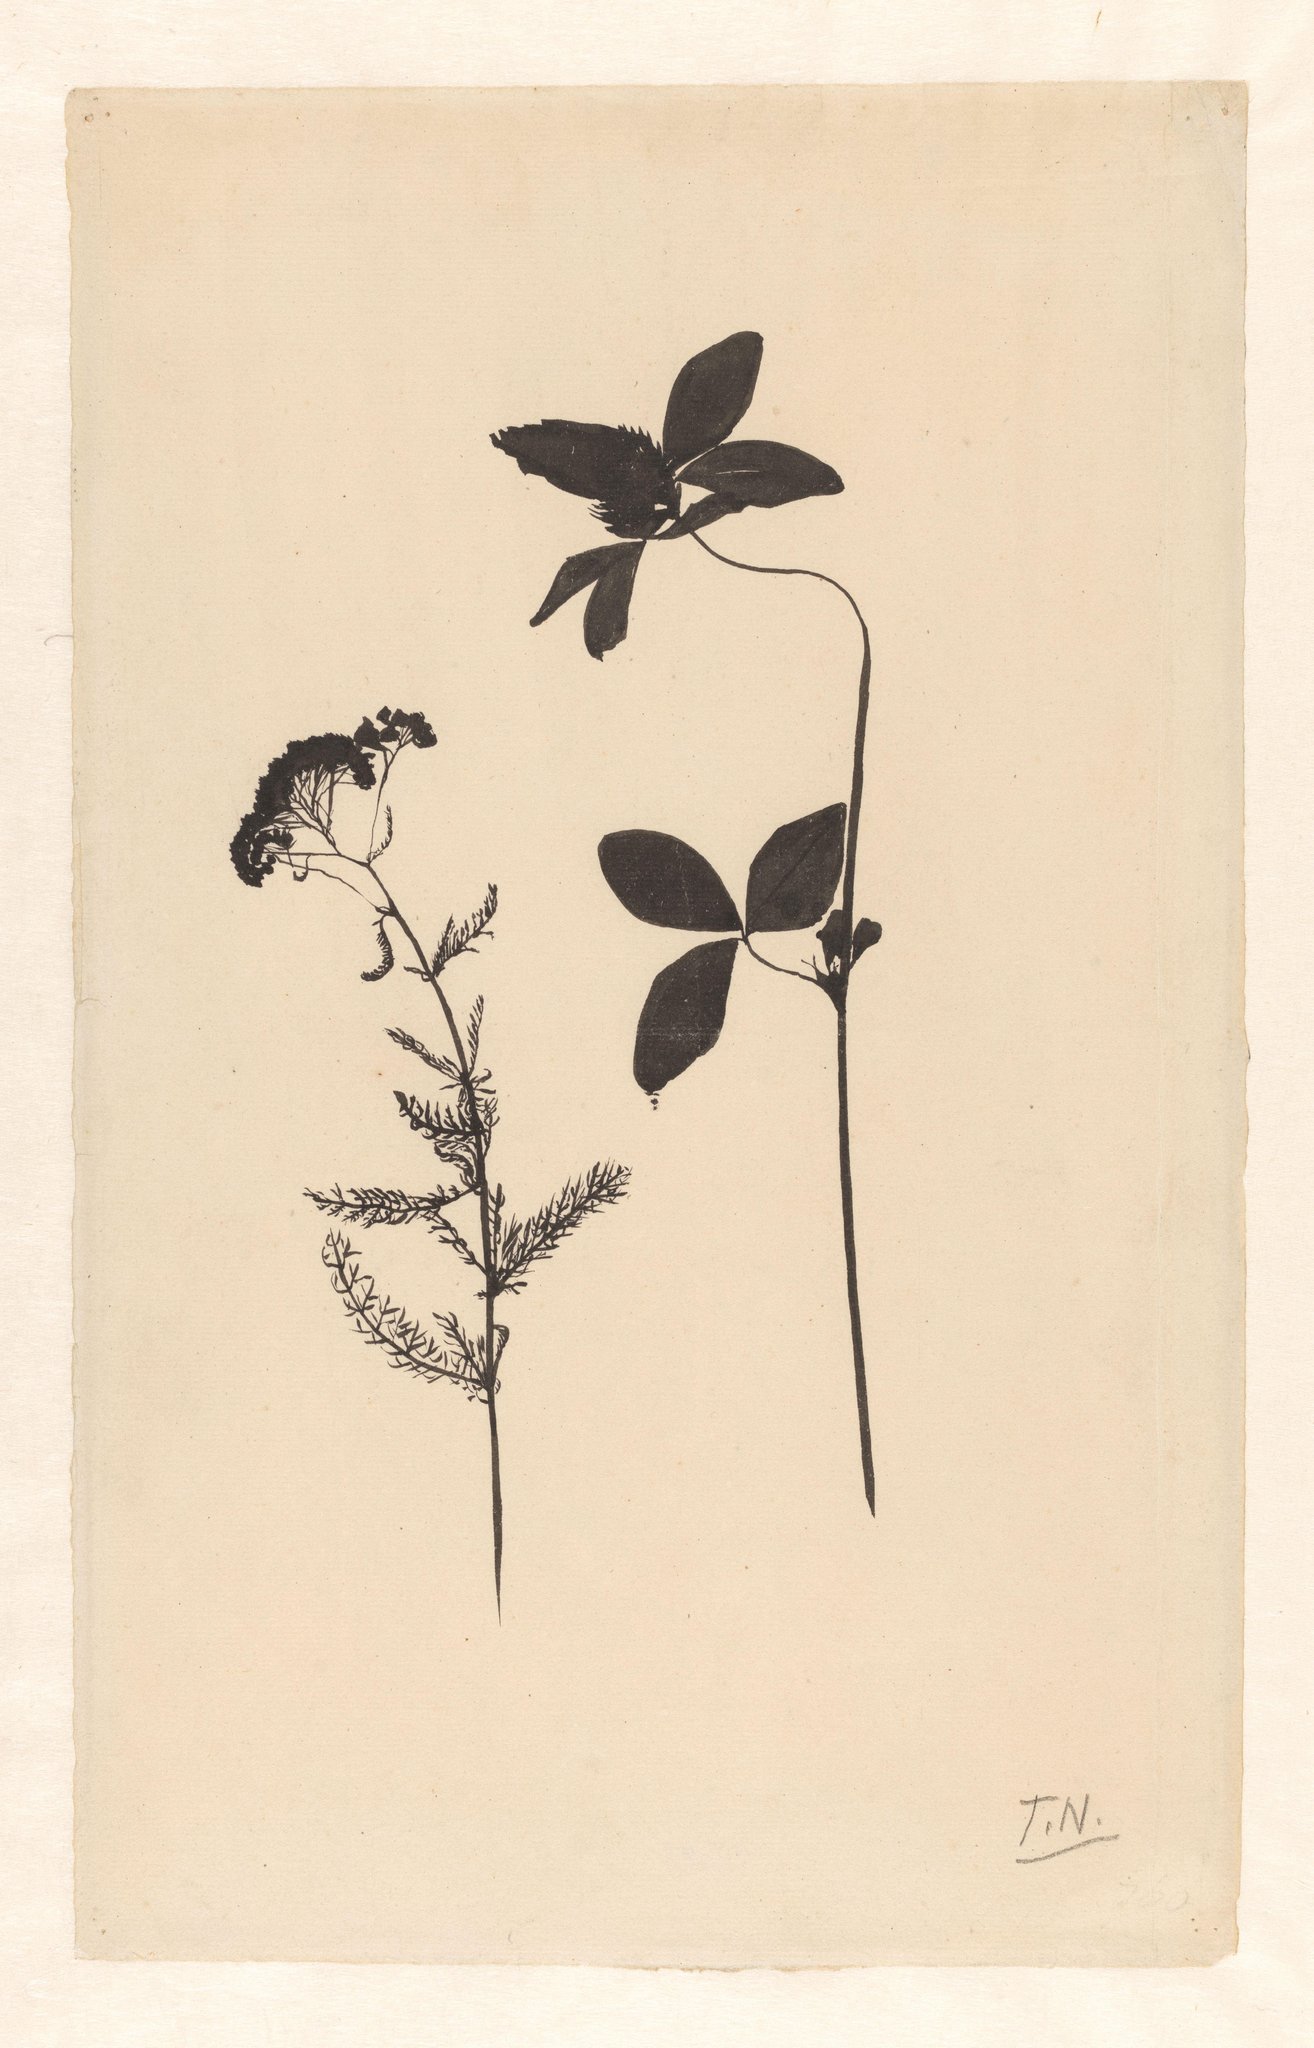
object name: drawing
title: Klaver en een andere plant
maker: theo nieuwenhuis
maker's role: designer, draughtsman, print maker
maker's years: 1866-1951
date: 1876-1951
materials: paper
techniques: brush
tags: plants and herbs: clover